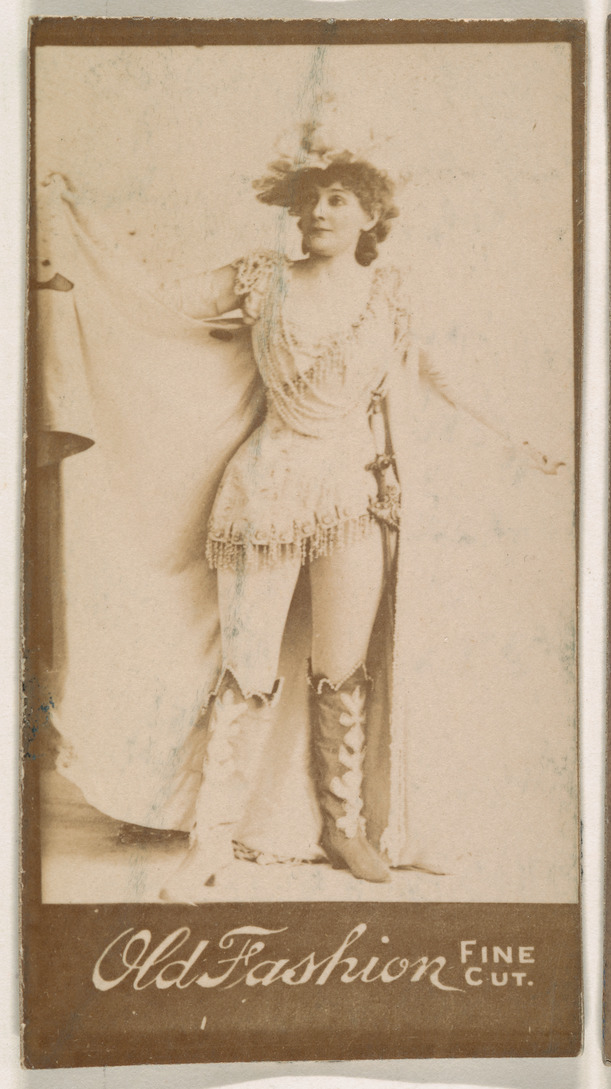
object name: photograph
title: Actress posing with arms aloft, from the Actresses series (N664) promoting Old Fashion Fine Cut Tobacco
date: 1888-1890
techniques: albumen silver print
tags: portraits,women,actresses